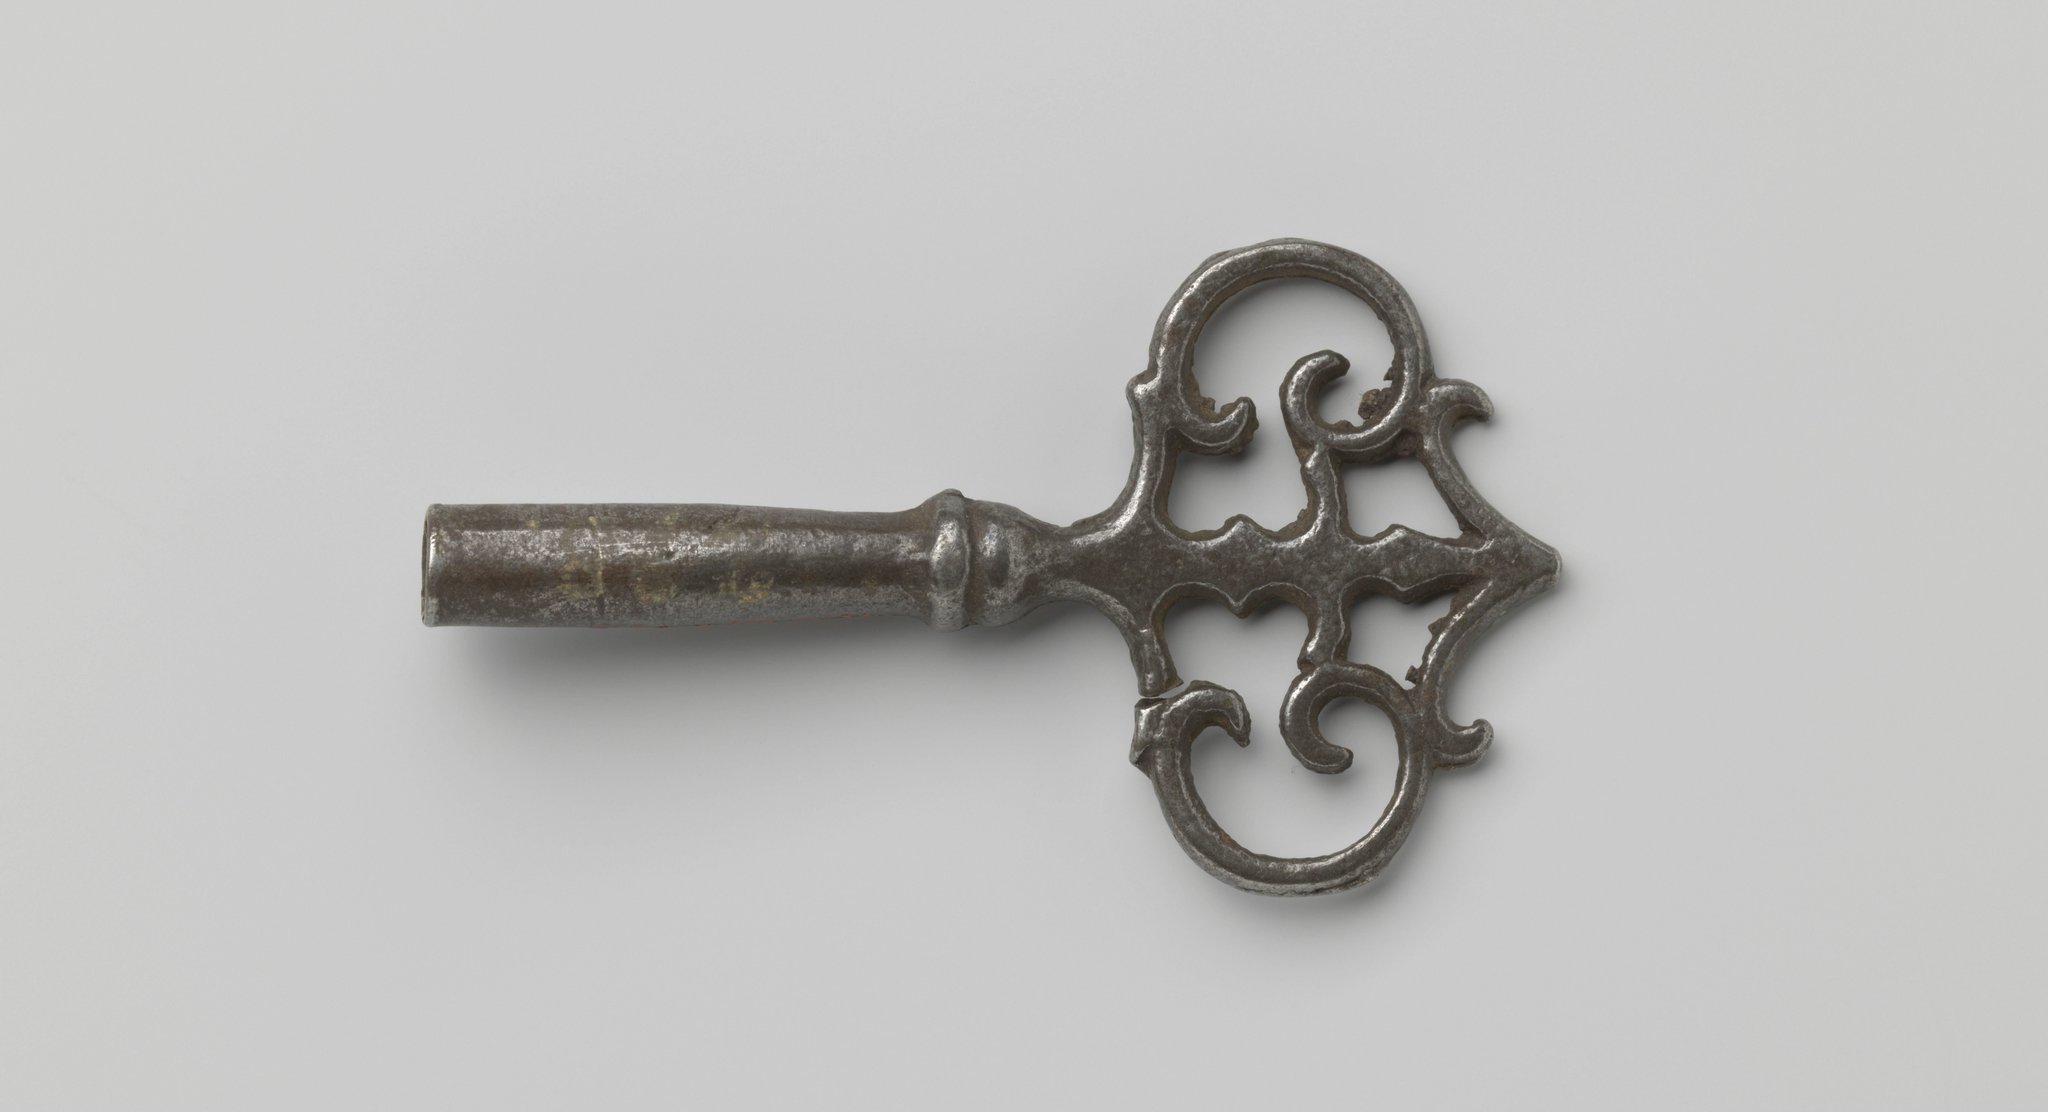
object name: open end wrench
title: Steeksleutel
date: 1800-1900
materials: iron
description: Steeksleutel behorend bij een klok. De greep bestaat uit twee naar elkaar toegewende C-voluten een zesarmige stam insluitend.